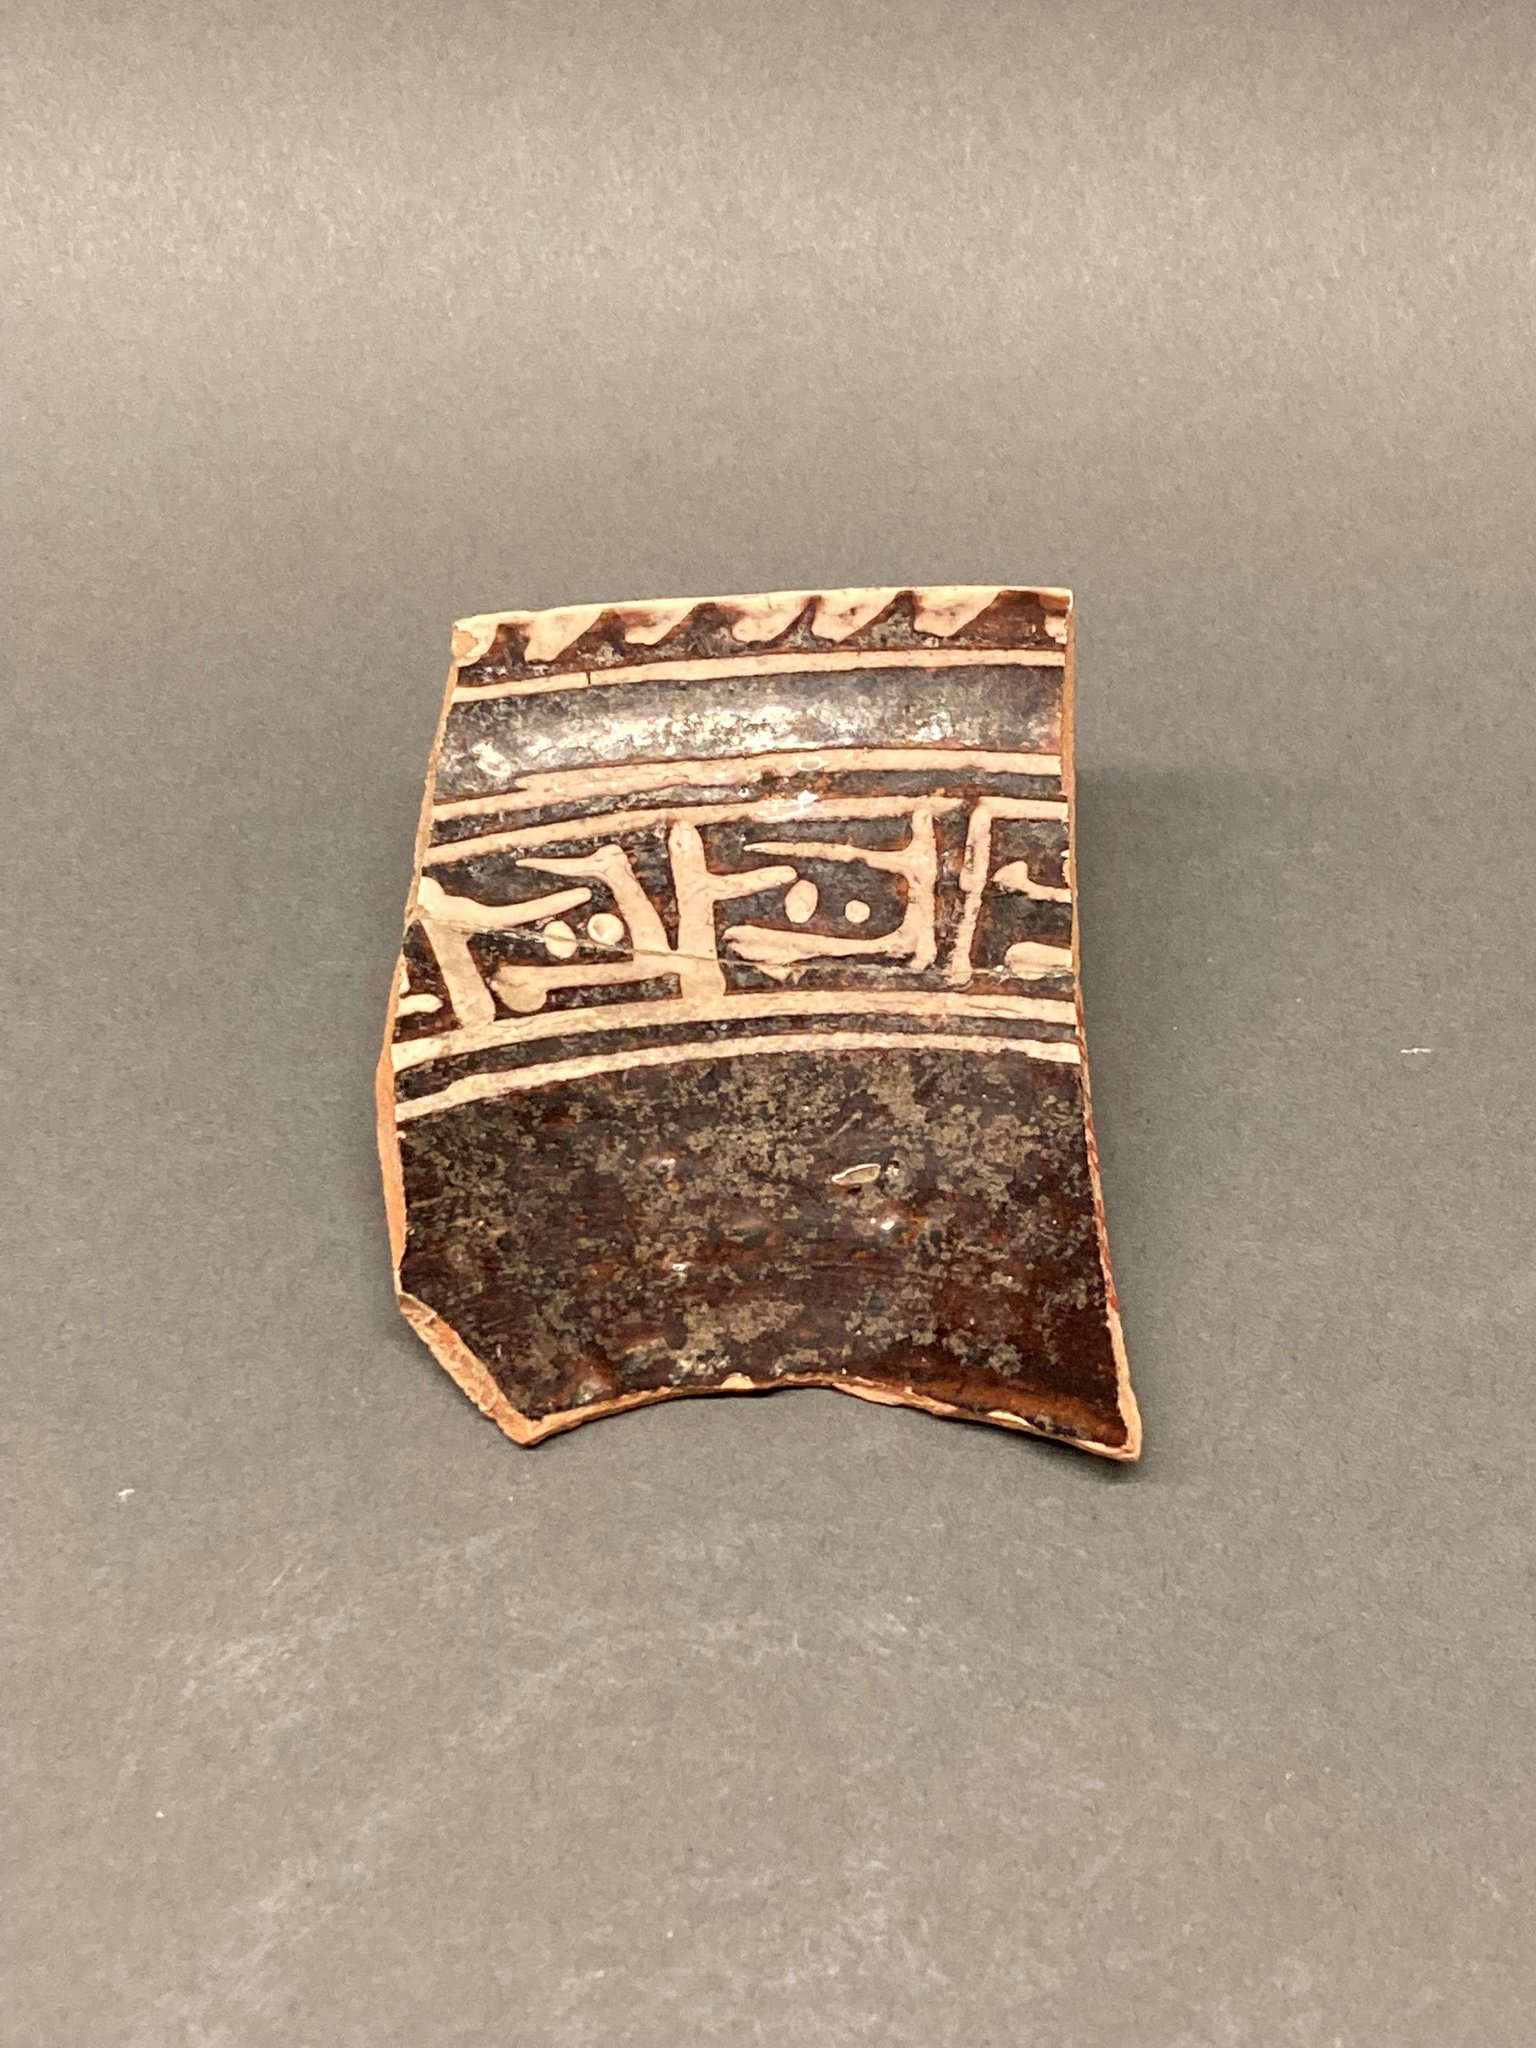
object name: fragment of a bowl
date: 901-1000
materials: earthenware, glaze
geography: iran